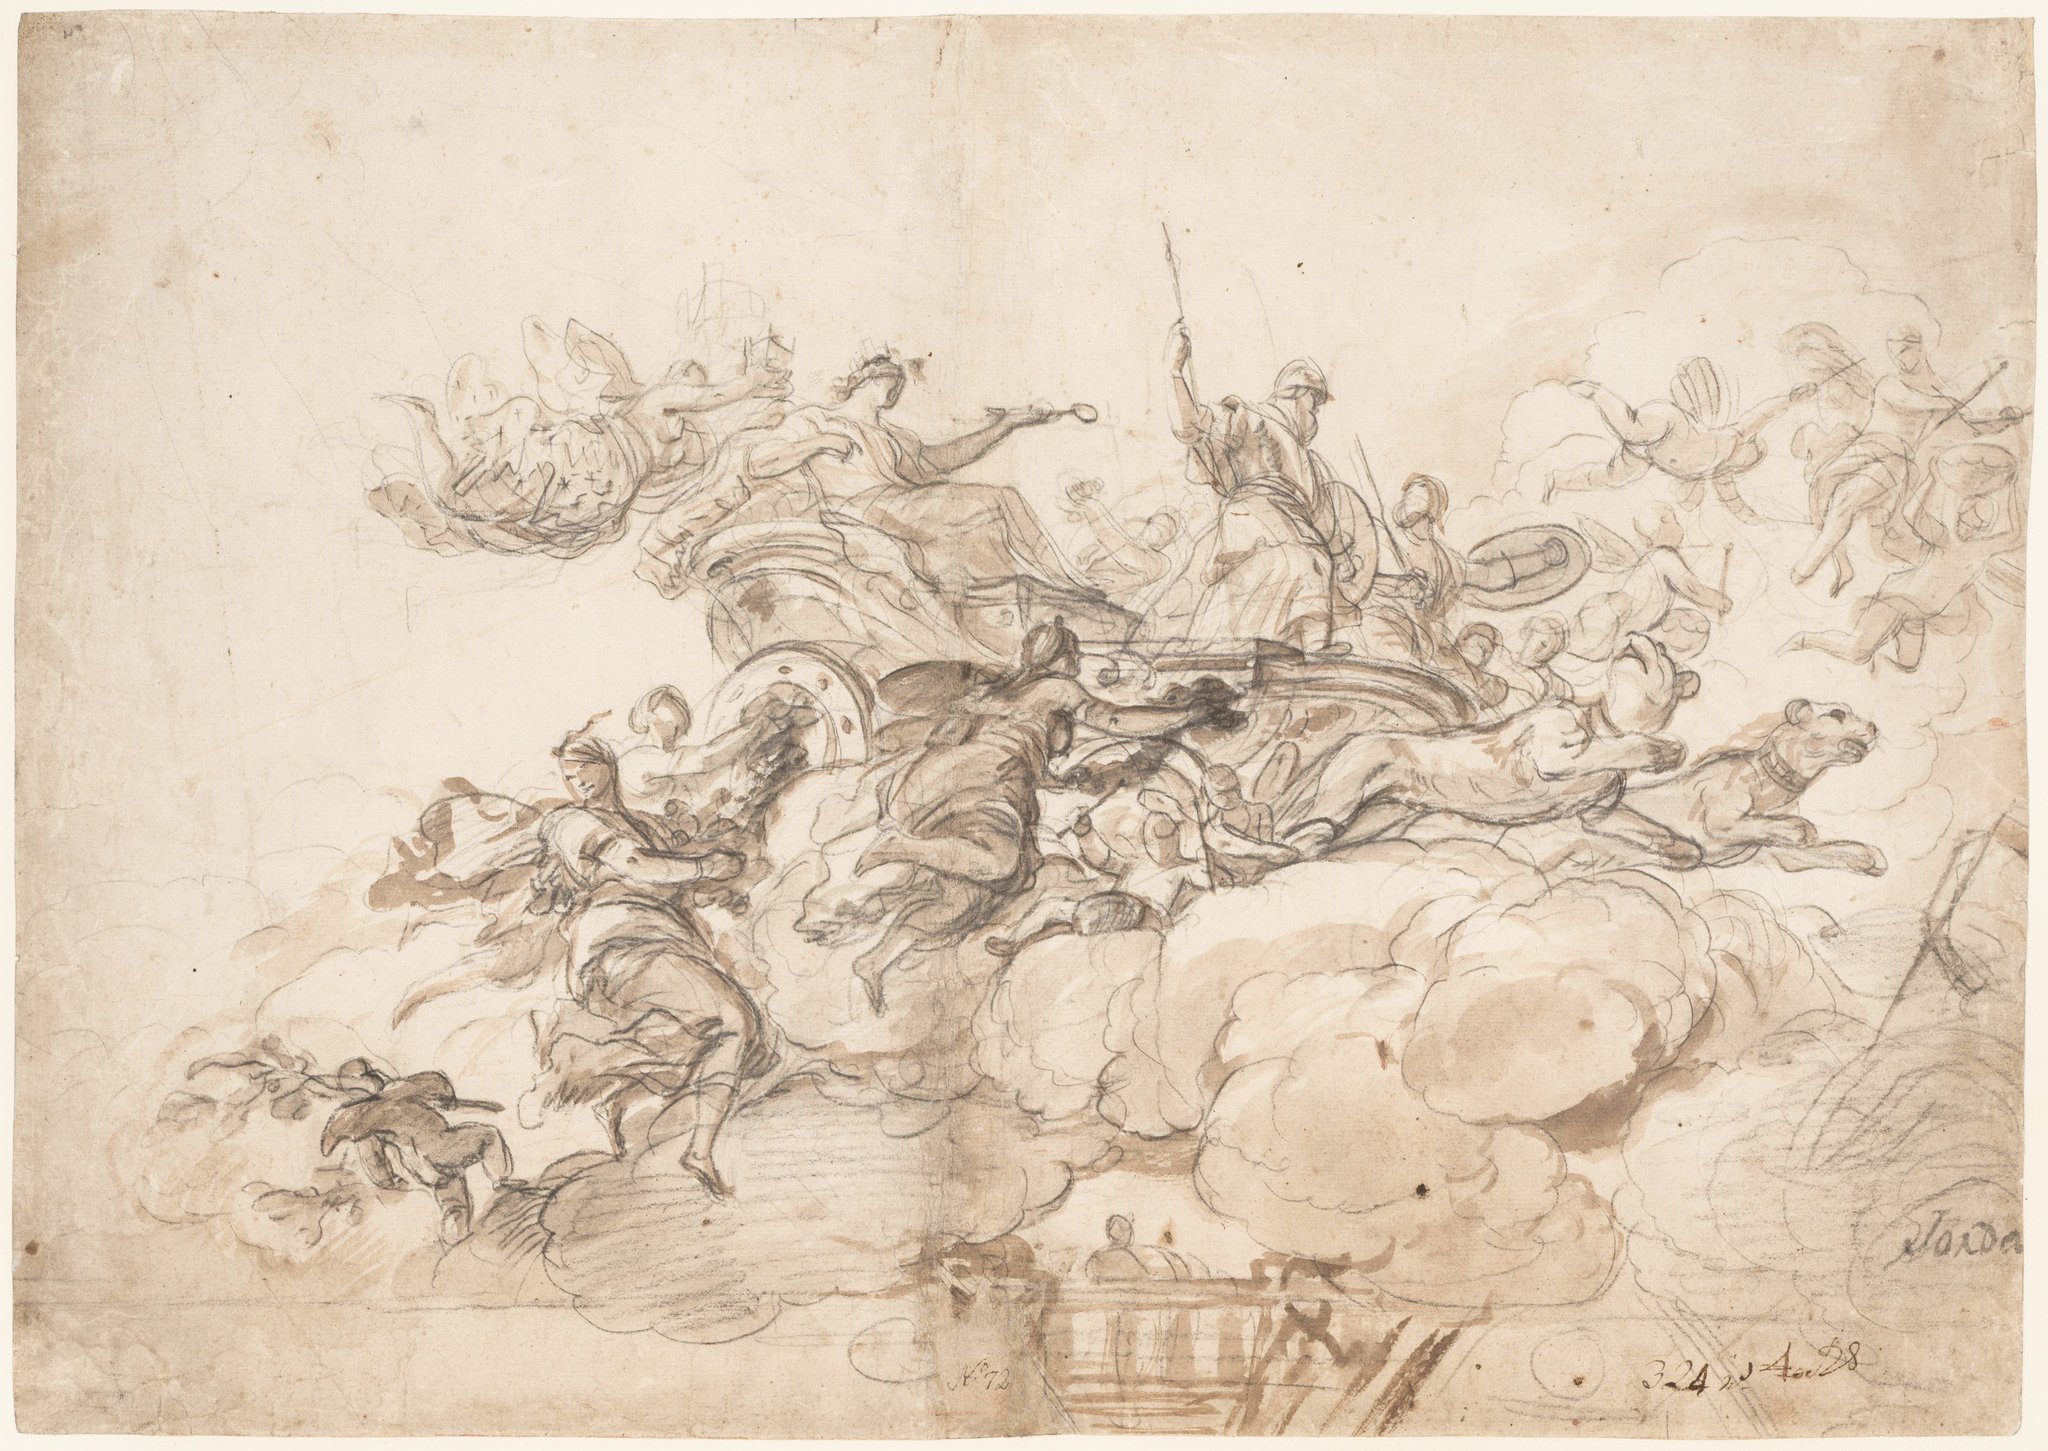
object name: drawing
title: The Triumph of Cybele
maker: luca giordano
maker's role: artist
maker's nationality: italian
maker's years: 1634-1705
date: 1697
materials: chalk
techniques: brush, wash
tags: human figures,animals,battles,shields